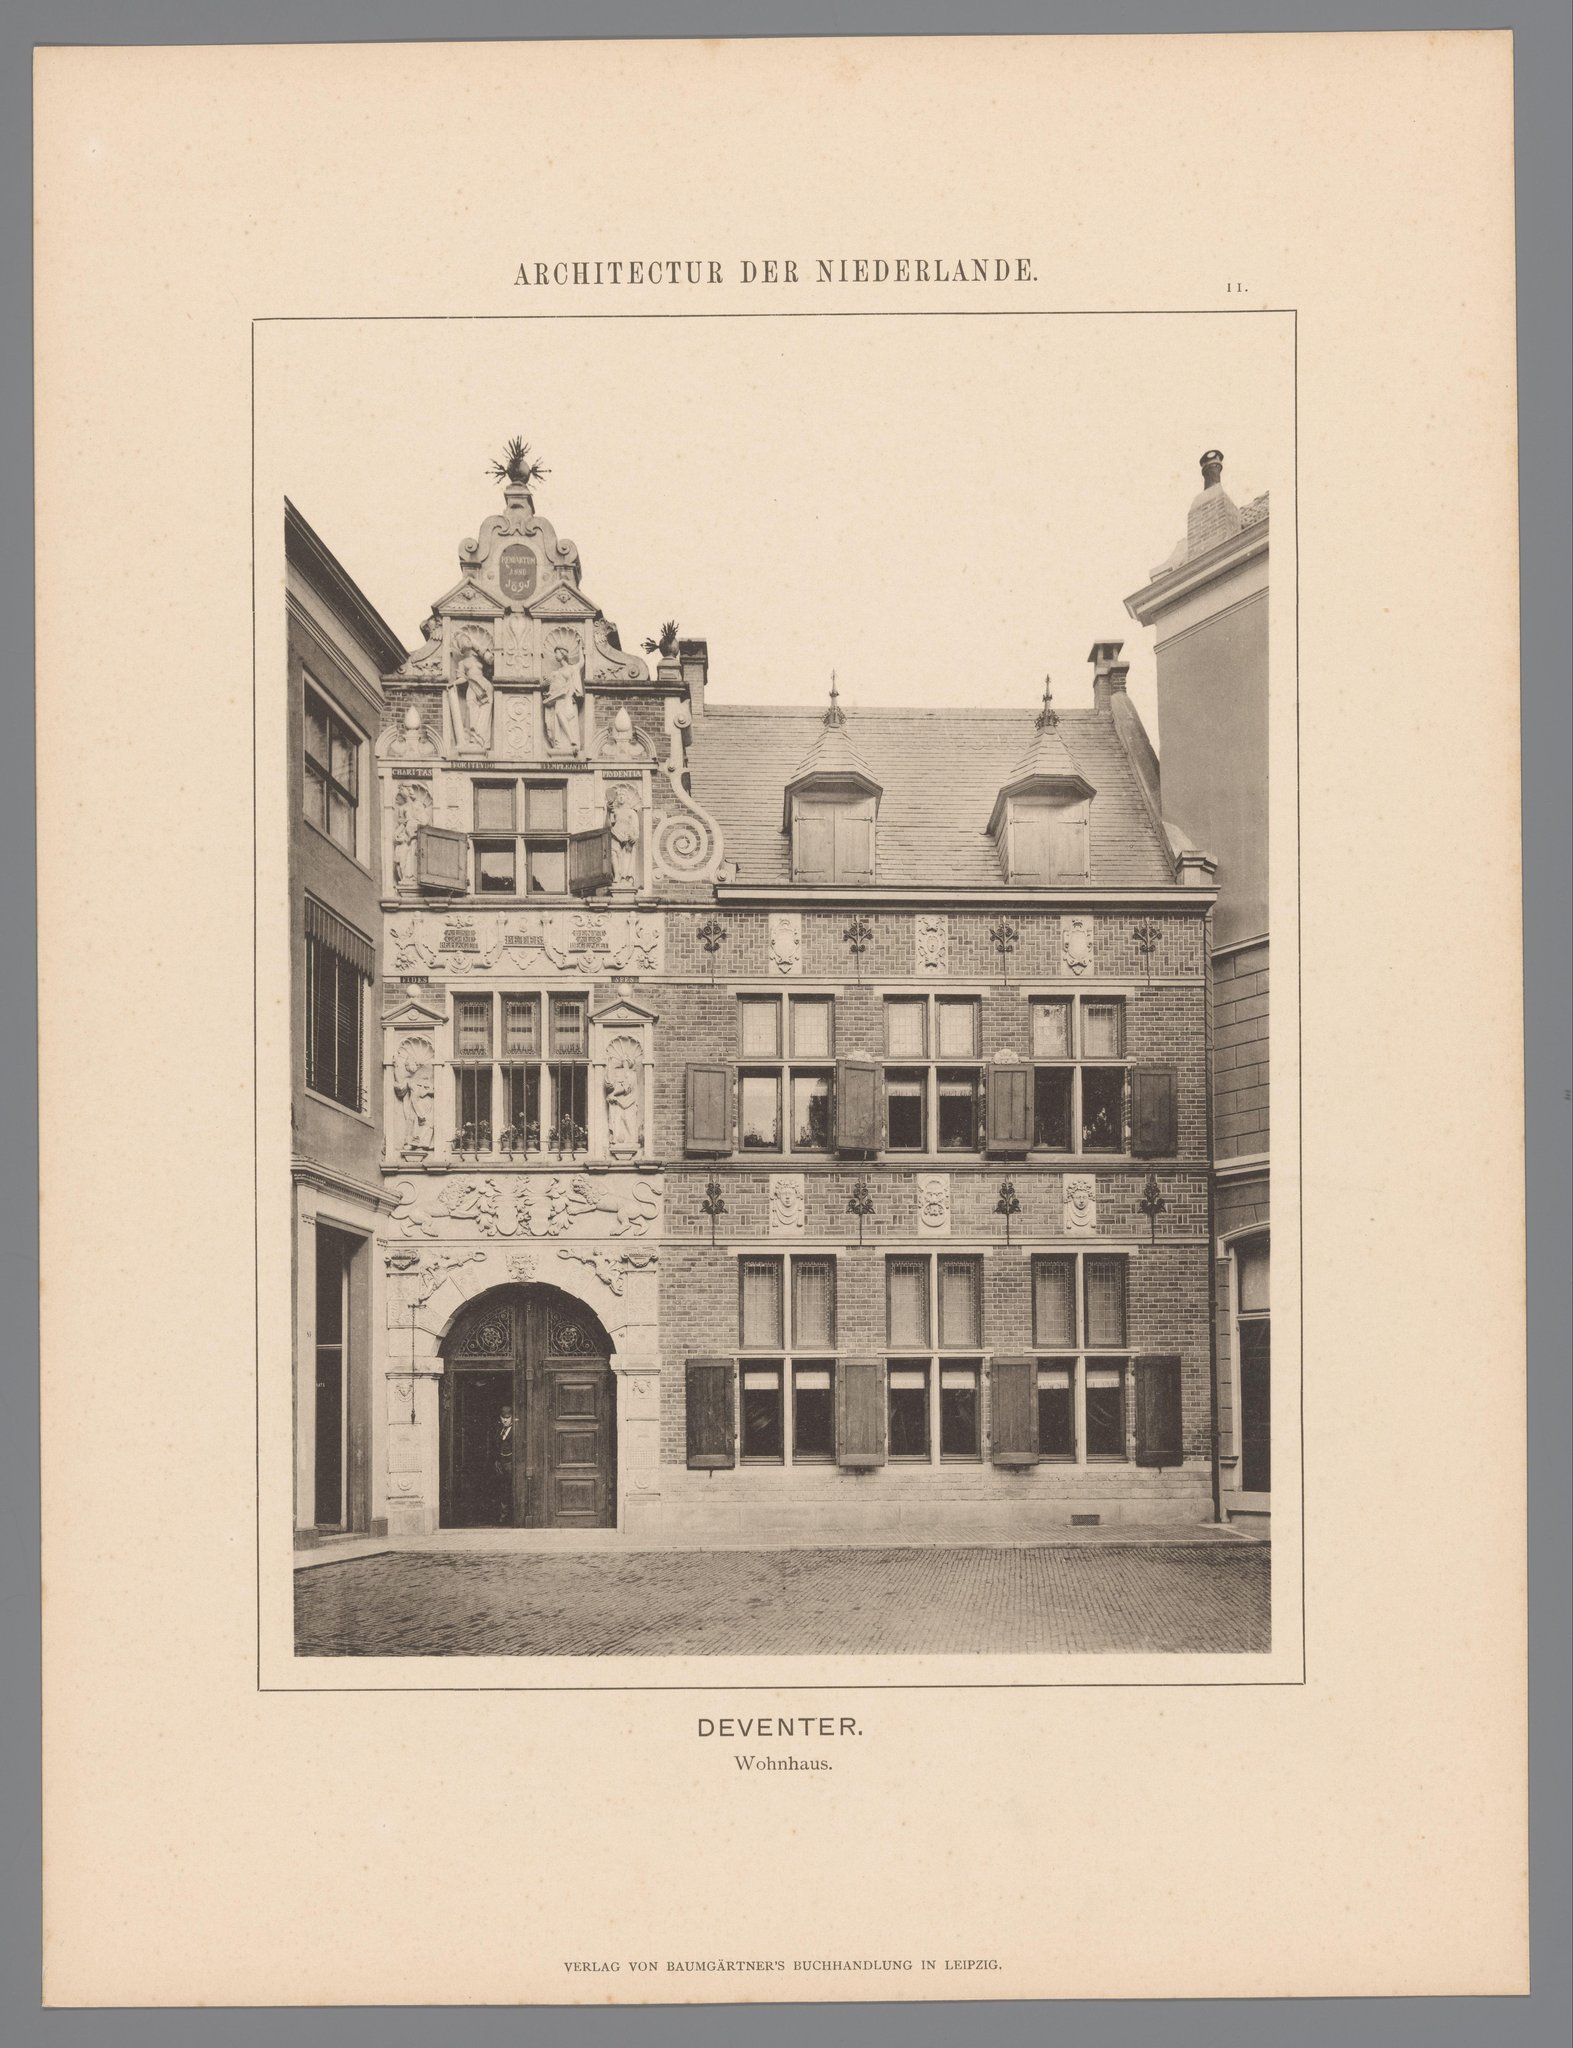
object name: photomechanical print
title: Deventer, Wohnhaus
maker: Anonymous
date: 1894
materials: paper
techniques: photograph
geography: leipzig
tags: urban housing, exterior ~ representation of a building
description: Afdruk uit: Krook, L. Architectur der Niederlande. Leipzig: Baumgärtner's Buchhandlung, 1894.